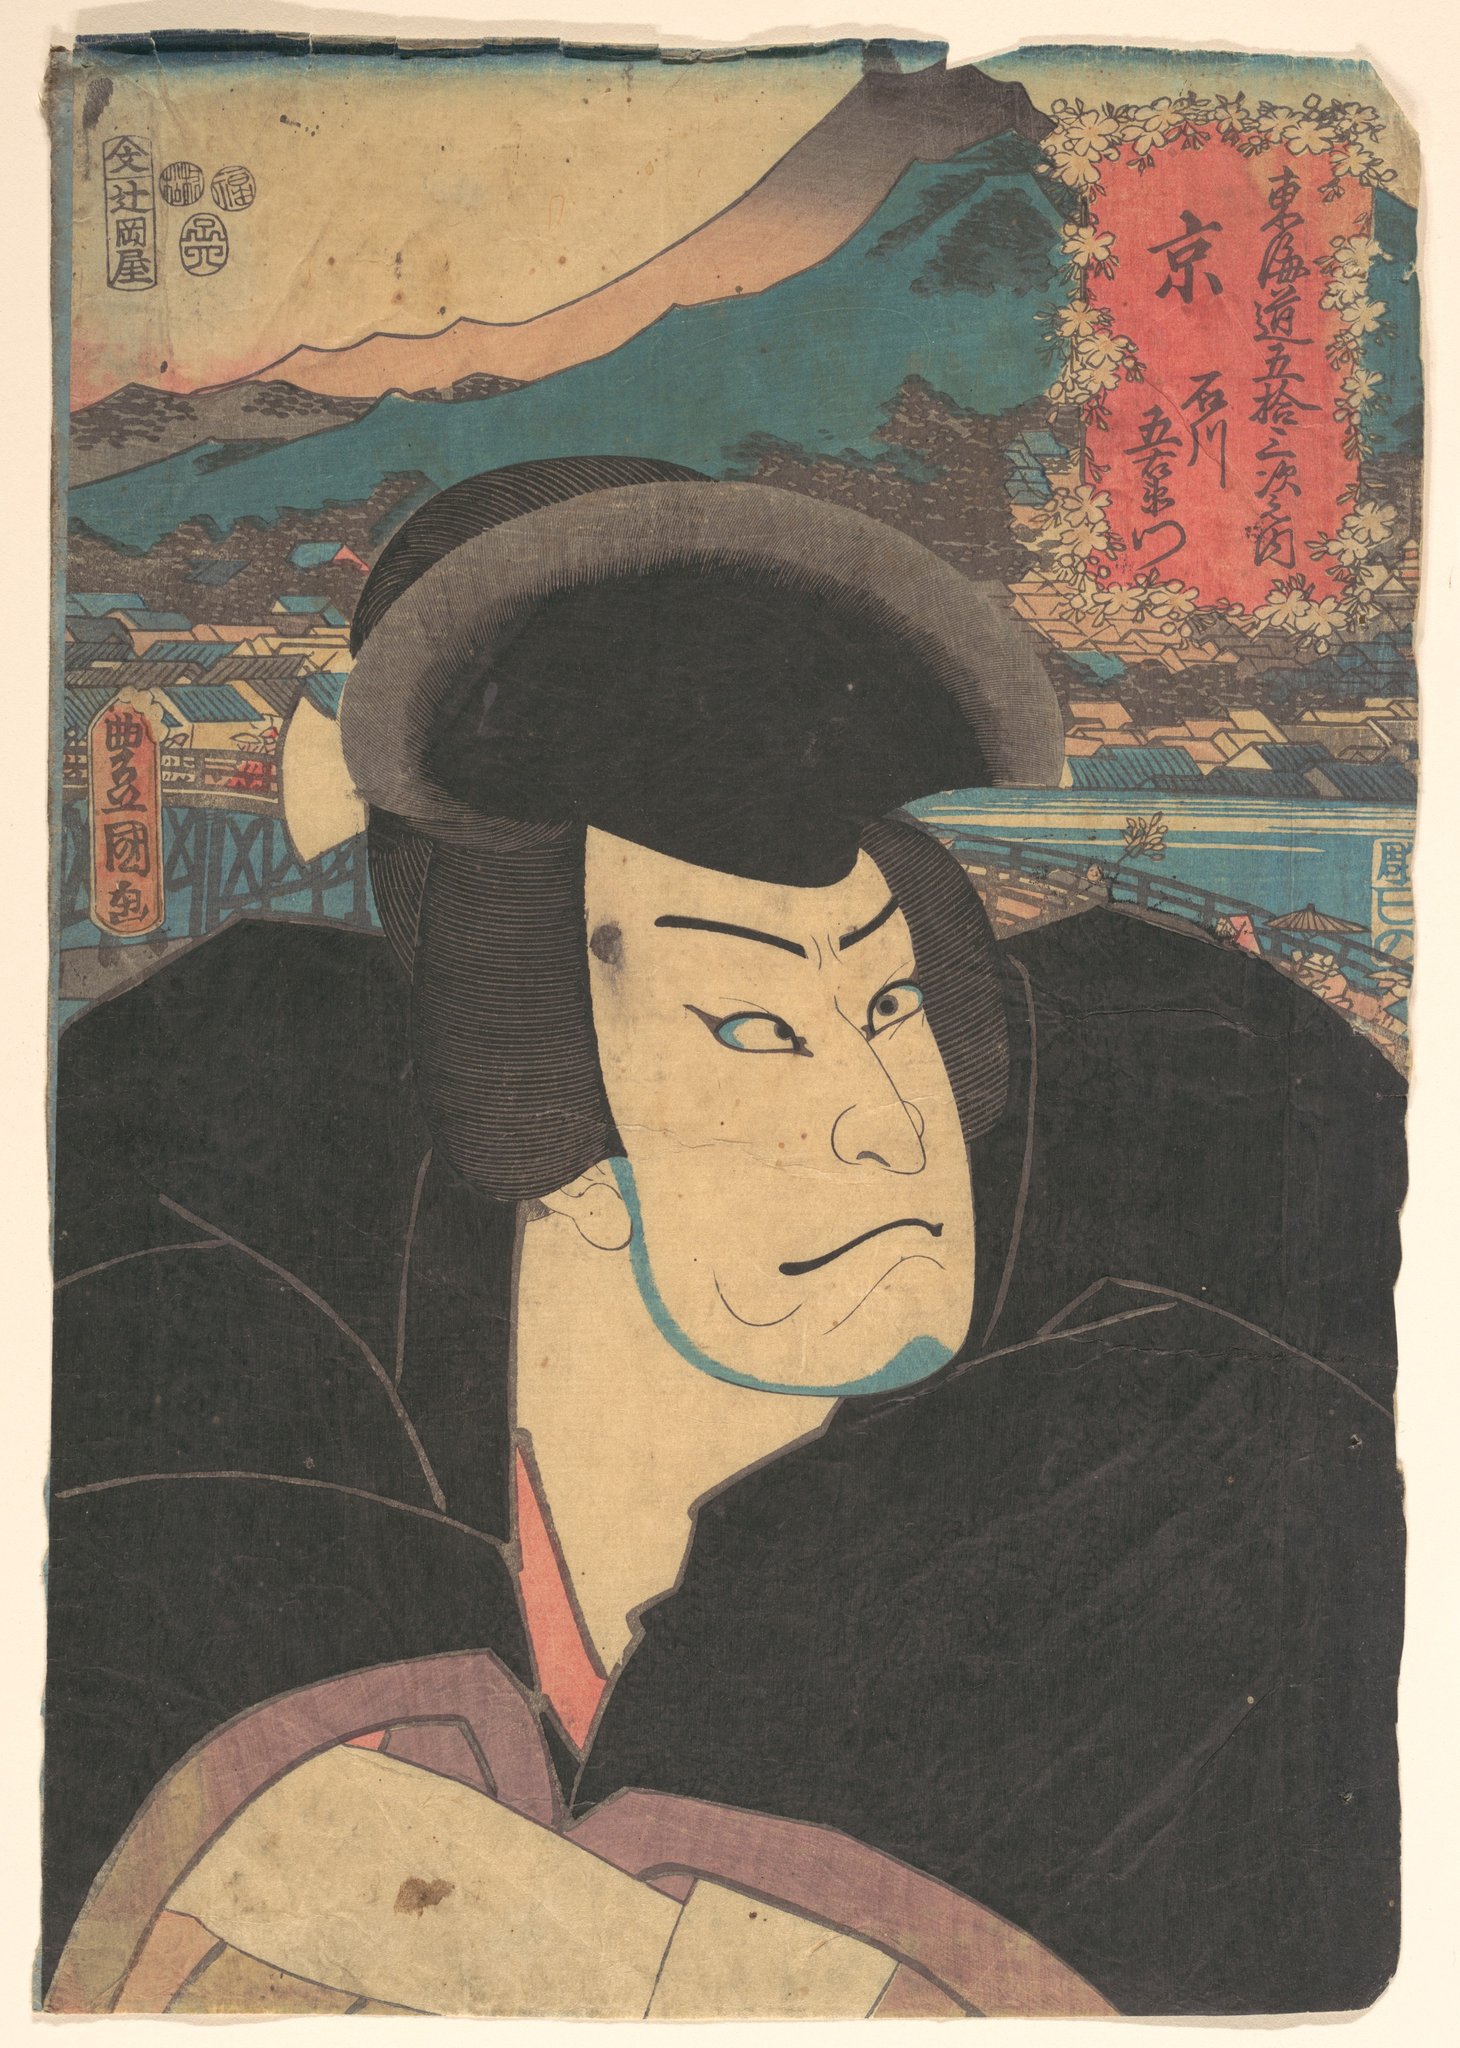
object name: print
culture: japanese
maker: utagawa kunisada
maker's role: artist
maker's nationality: japanese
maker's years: 1786-1864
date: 1801-1900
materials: ink, paper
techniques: woodblock print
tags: men,portraits,mountains